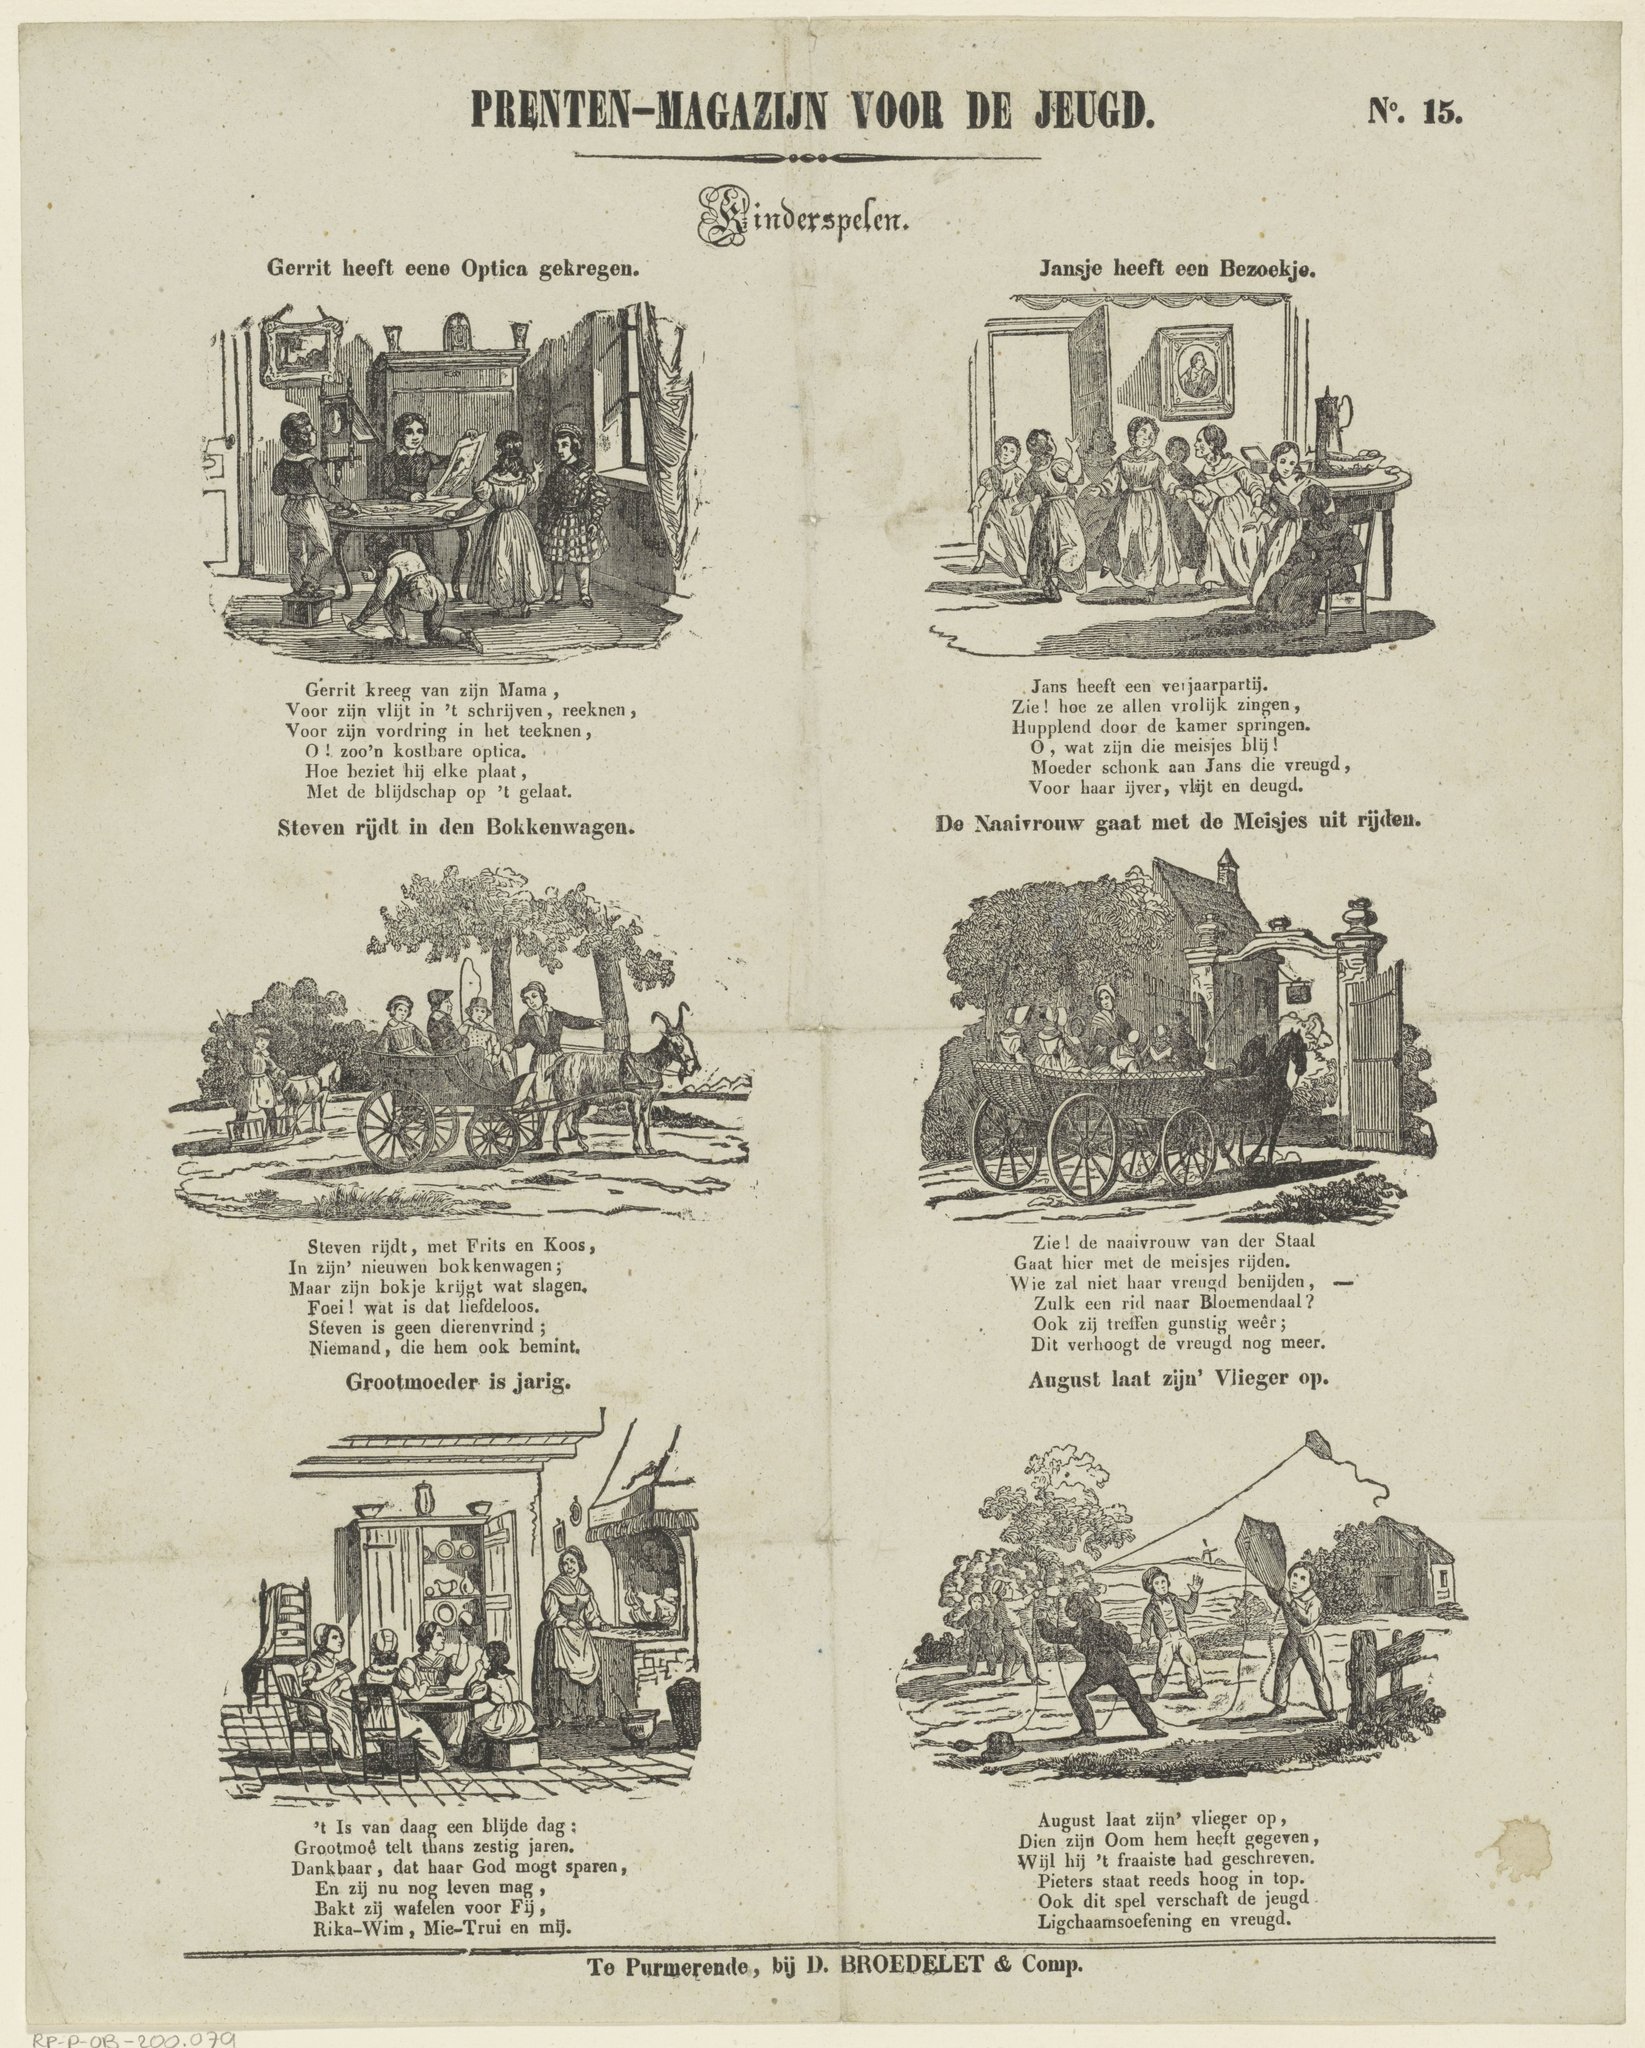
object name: popular print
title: Prenten-magazijn voor de jeugd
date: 1839-1841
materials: paper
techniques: letterpress printing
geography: purmerend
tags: children's games and plays, four-wheeled, animal-drawn vehicle, e.g.: cab, carriage, coach, (flying a) kite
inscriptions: collector's mark: Lugt 2760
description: Blad met 6 voorstellingen van kinderspelen, waaronder rijden in een wagen en vliegeren. Boven elke voorstelling een titel en onder elke voorstelling een zesregelig vers. Genummerd rechtsboven: No. 15.